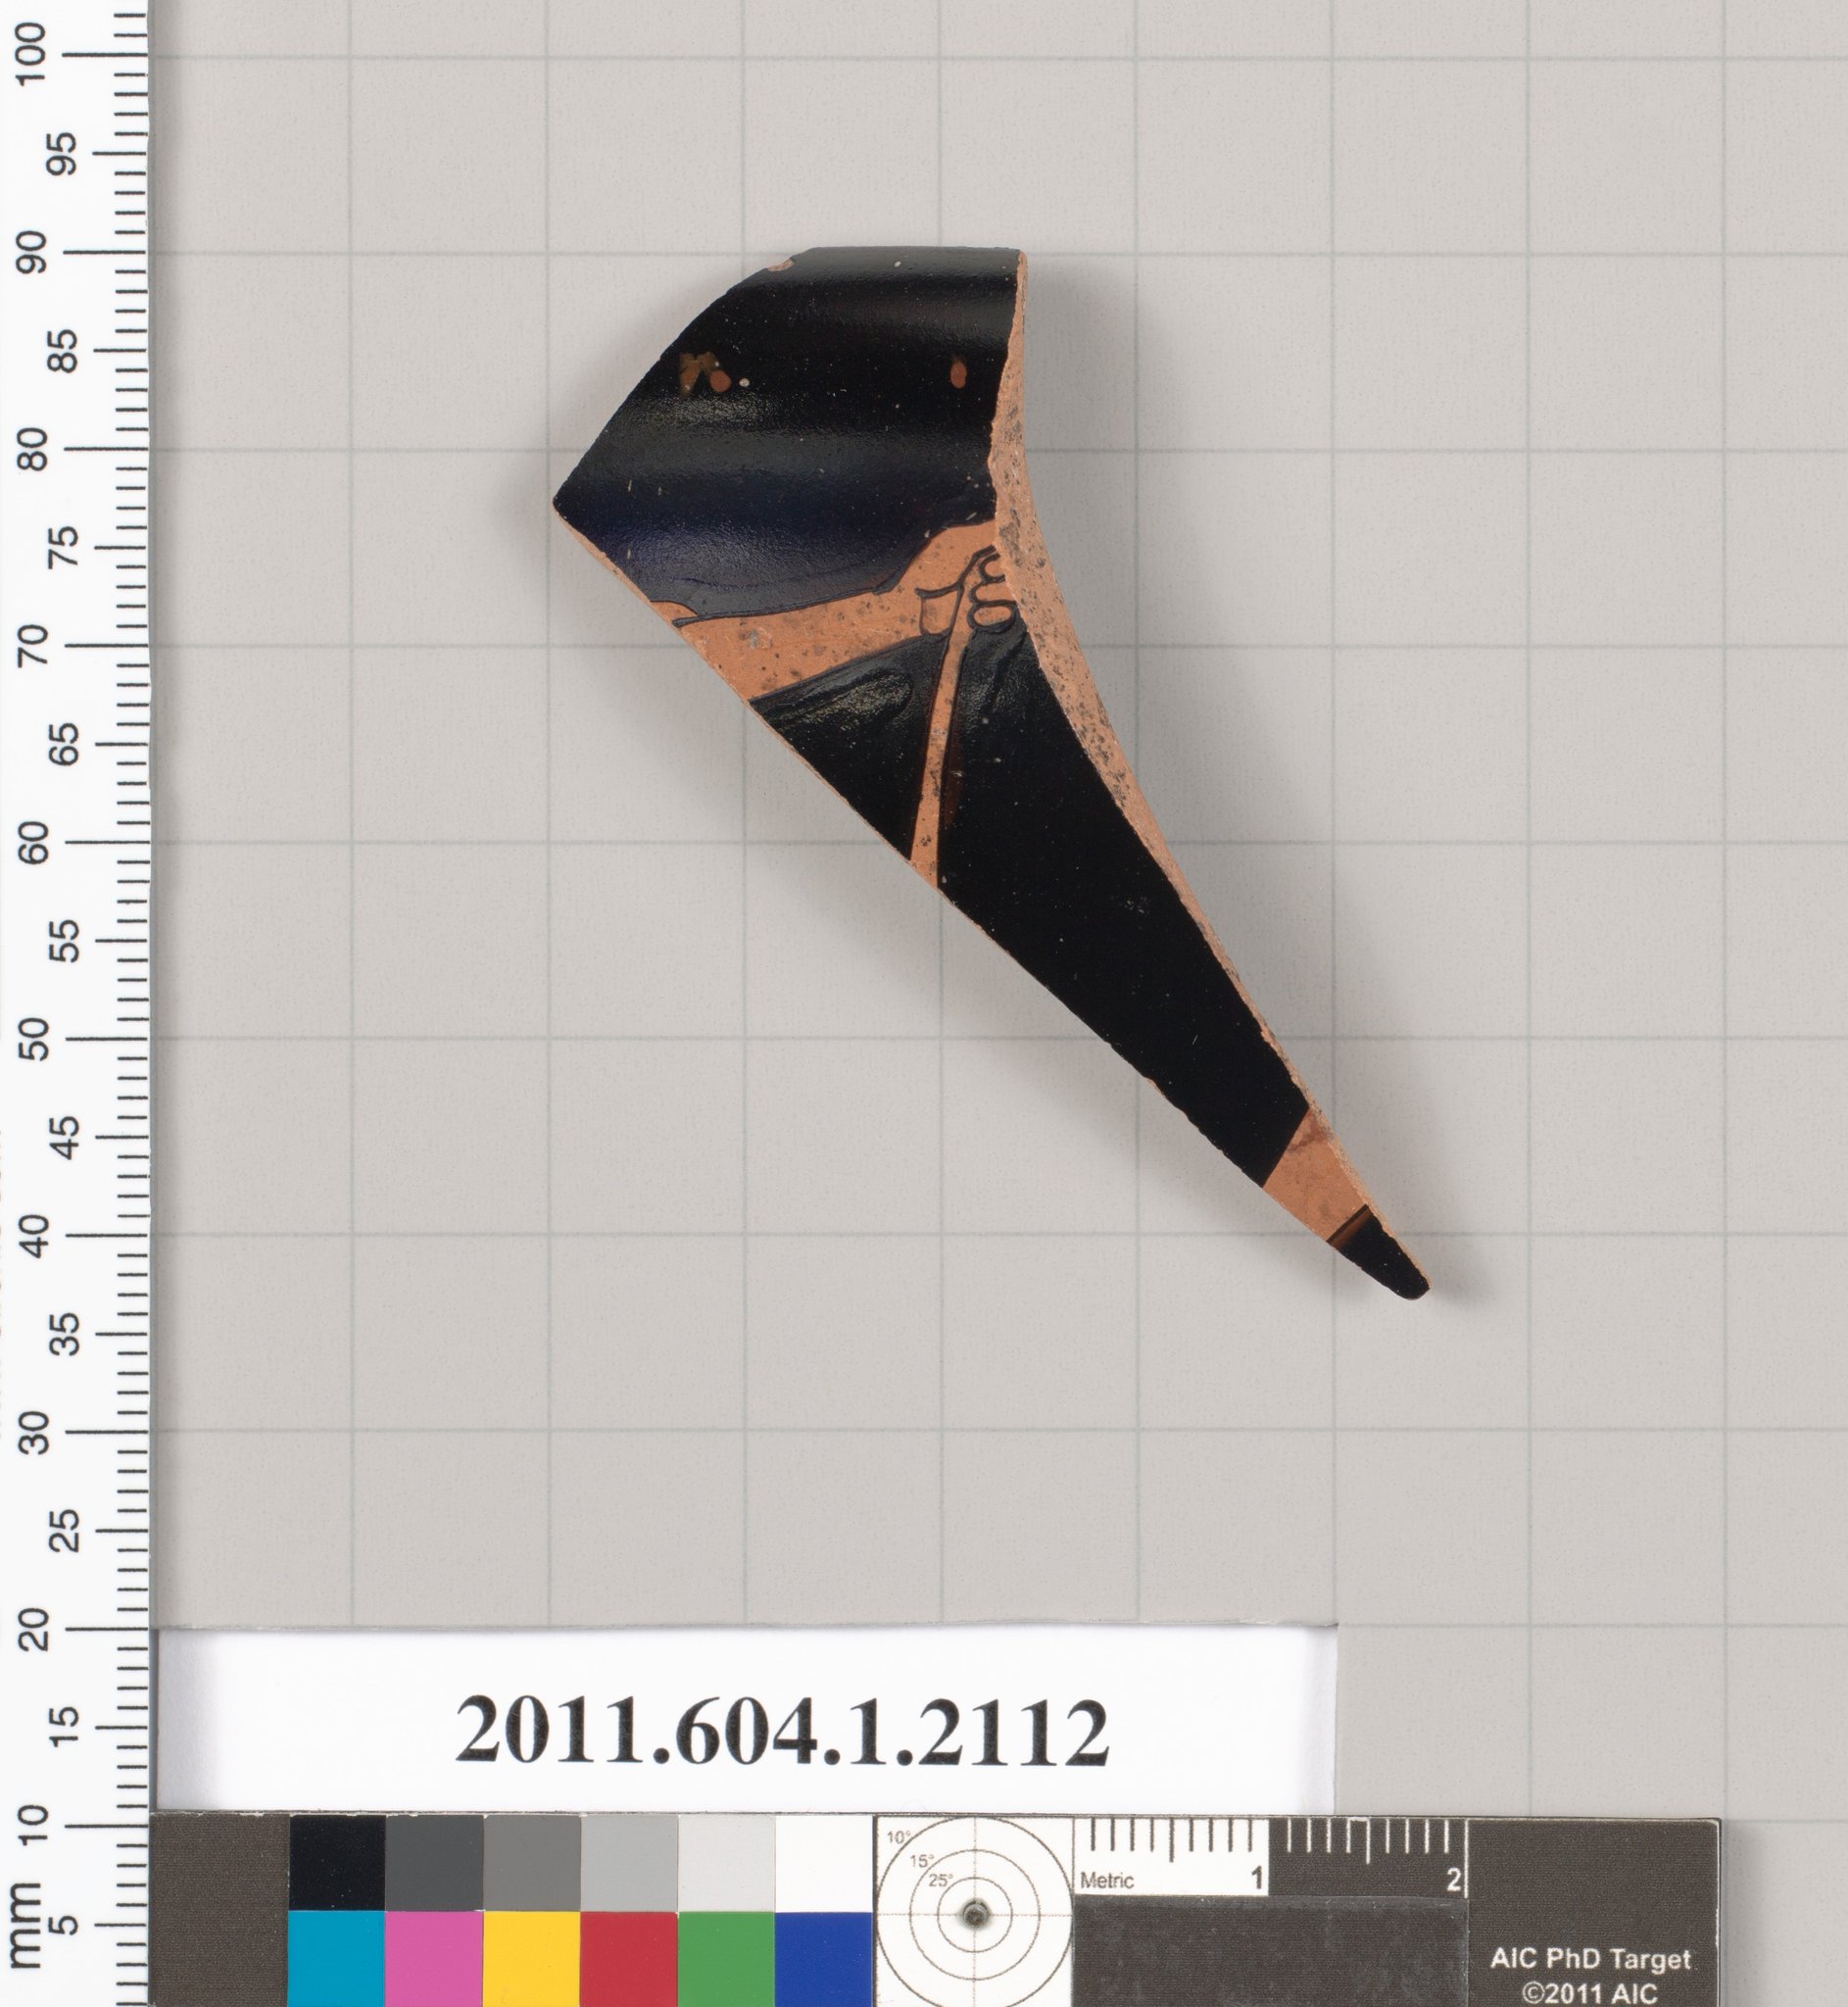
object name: kylix fragment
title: Terracotta rim fragment of a kylix (drinking cup)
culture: greek, attic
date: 490-480 BCE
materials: terracotta